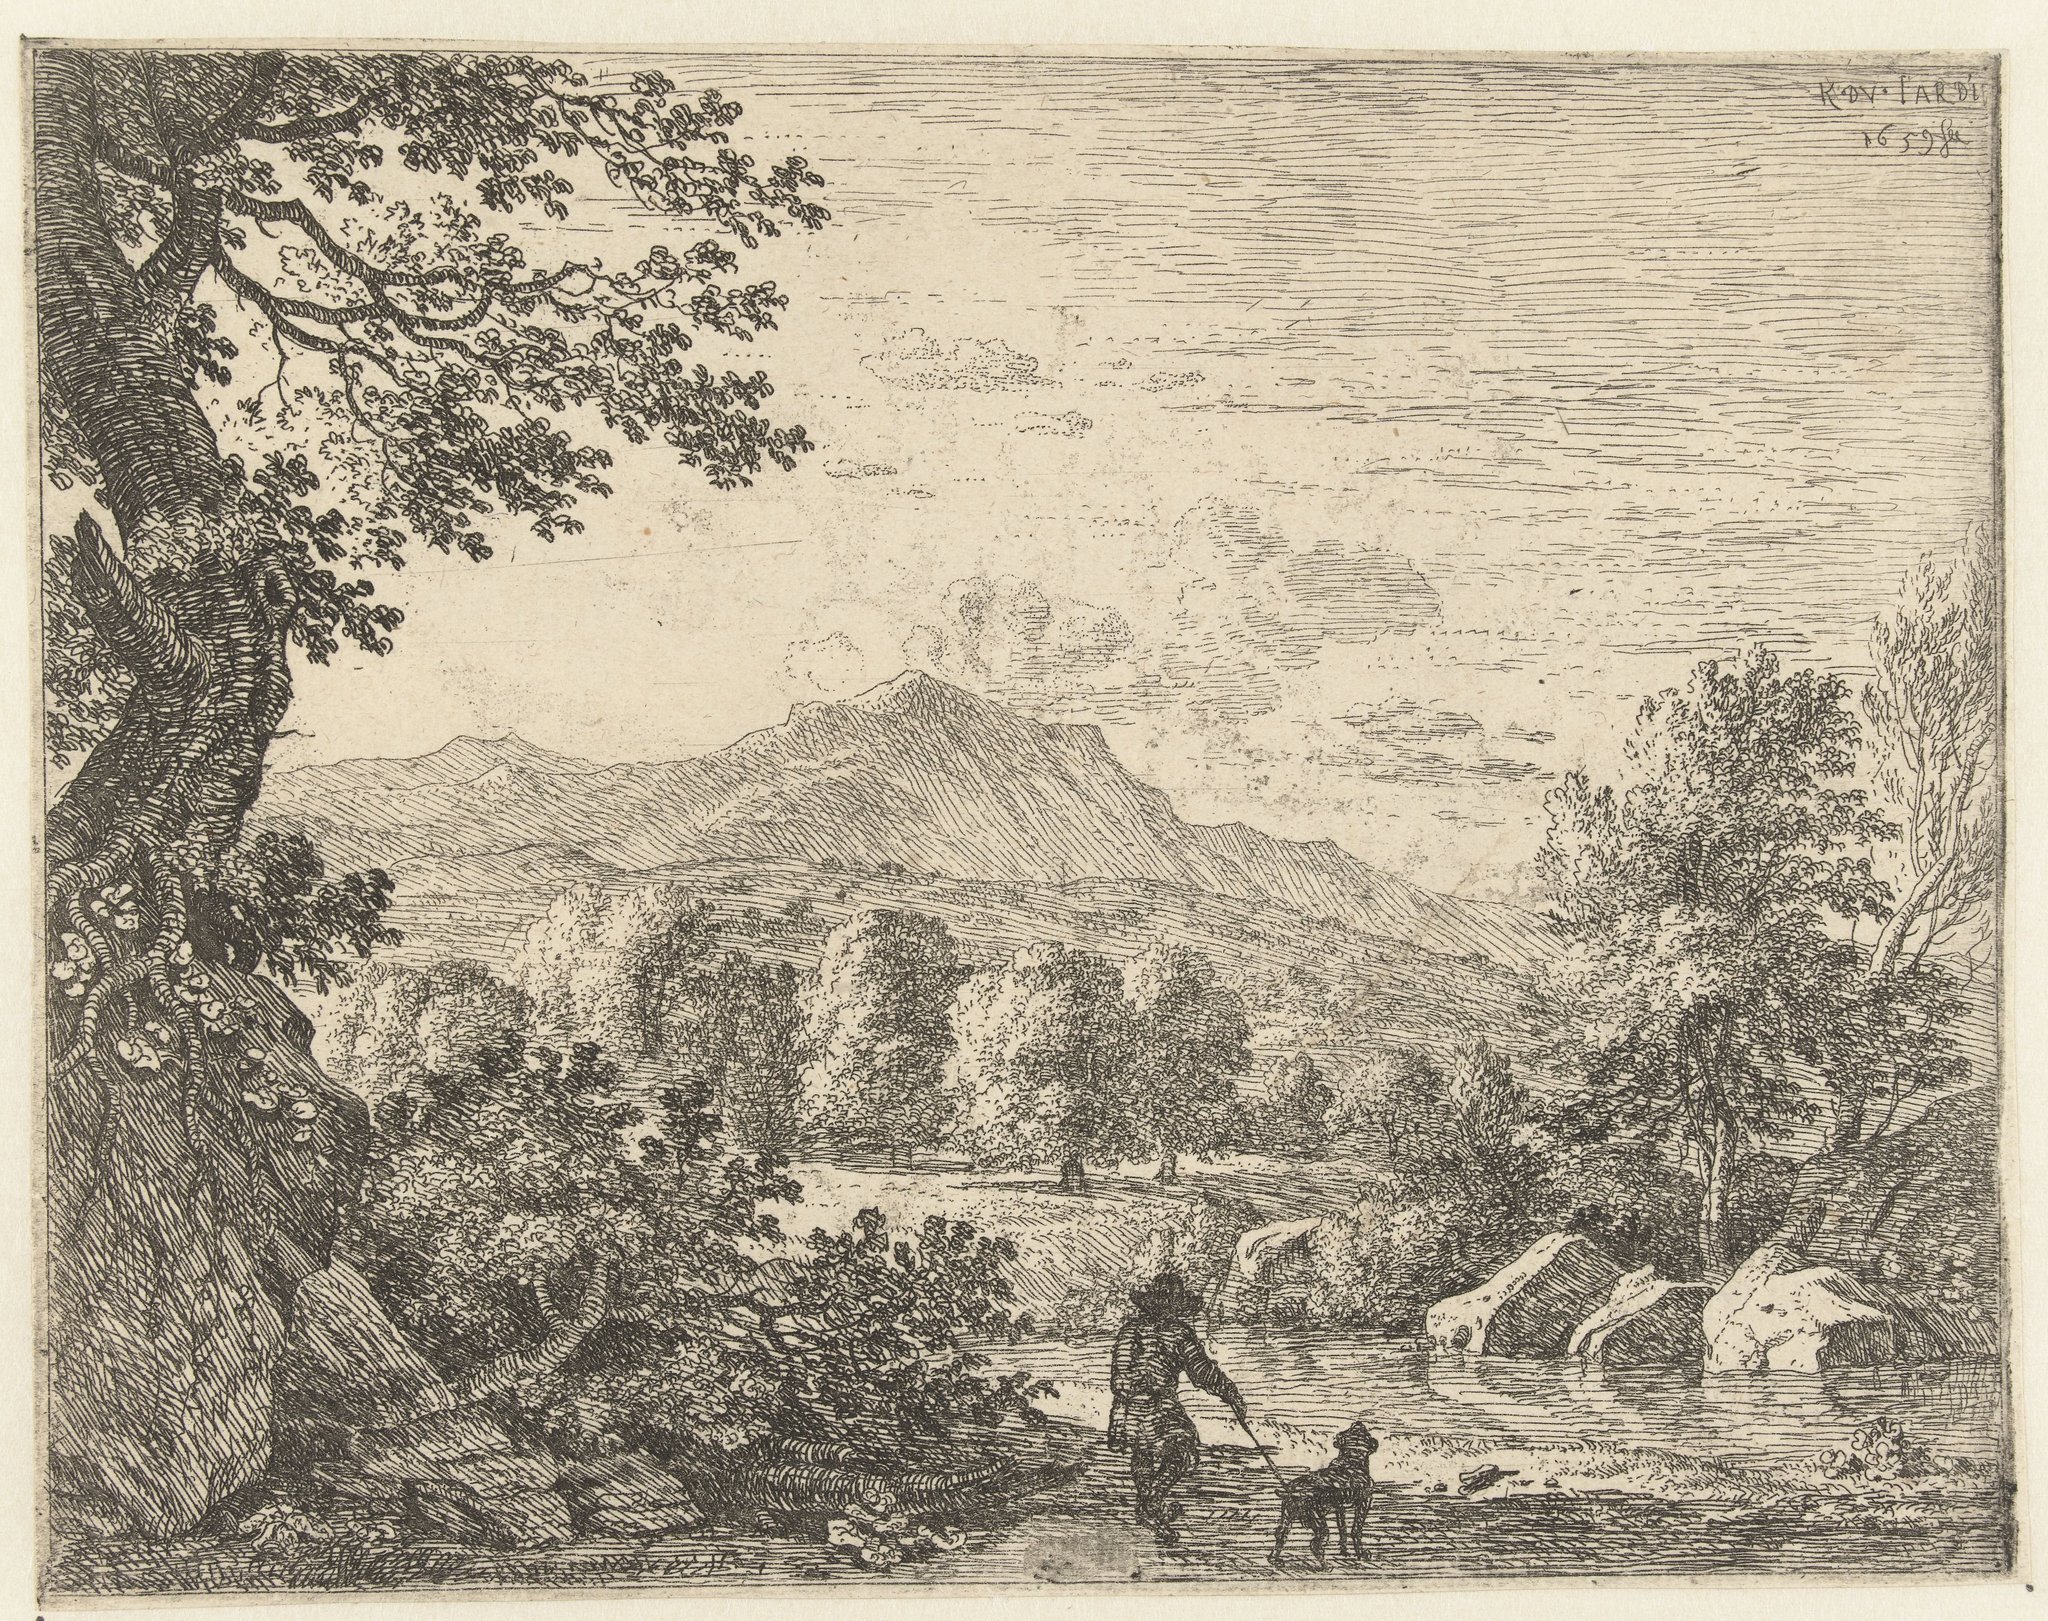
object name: print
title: Heuvellandschap met man en hond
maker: karel du jardin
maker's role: draughtsman, painter, print maker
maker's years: 1626-1678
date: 1659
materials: paper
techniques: etching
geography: netherlands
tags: low hill country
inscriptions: collector's mark: Lugt 240